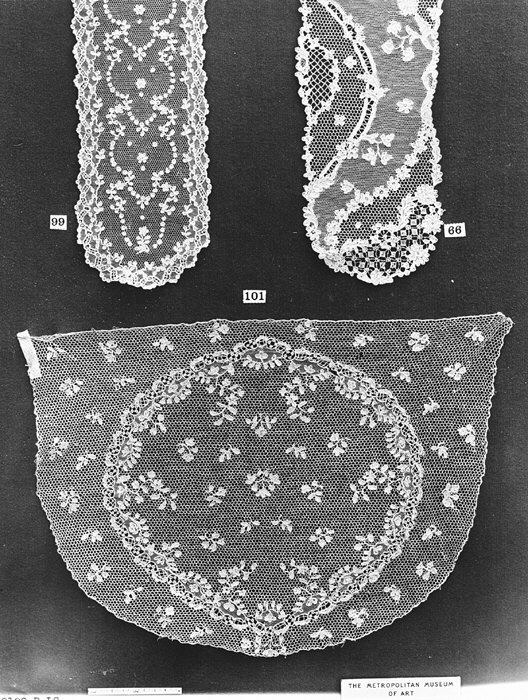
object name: barbe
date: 1701-1733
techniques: lace